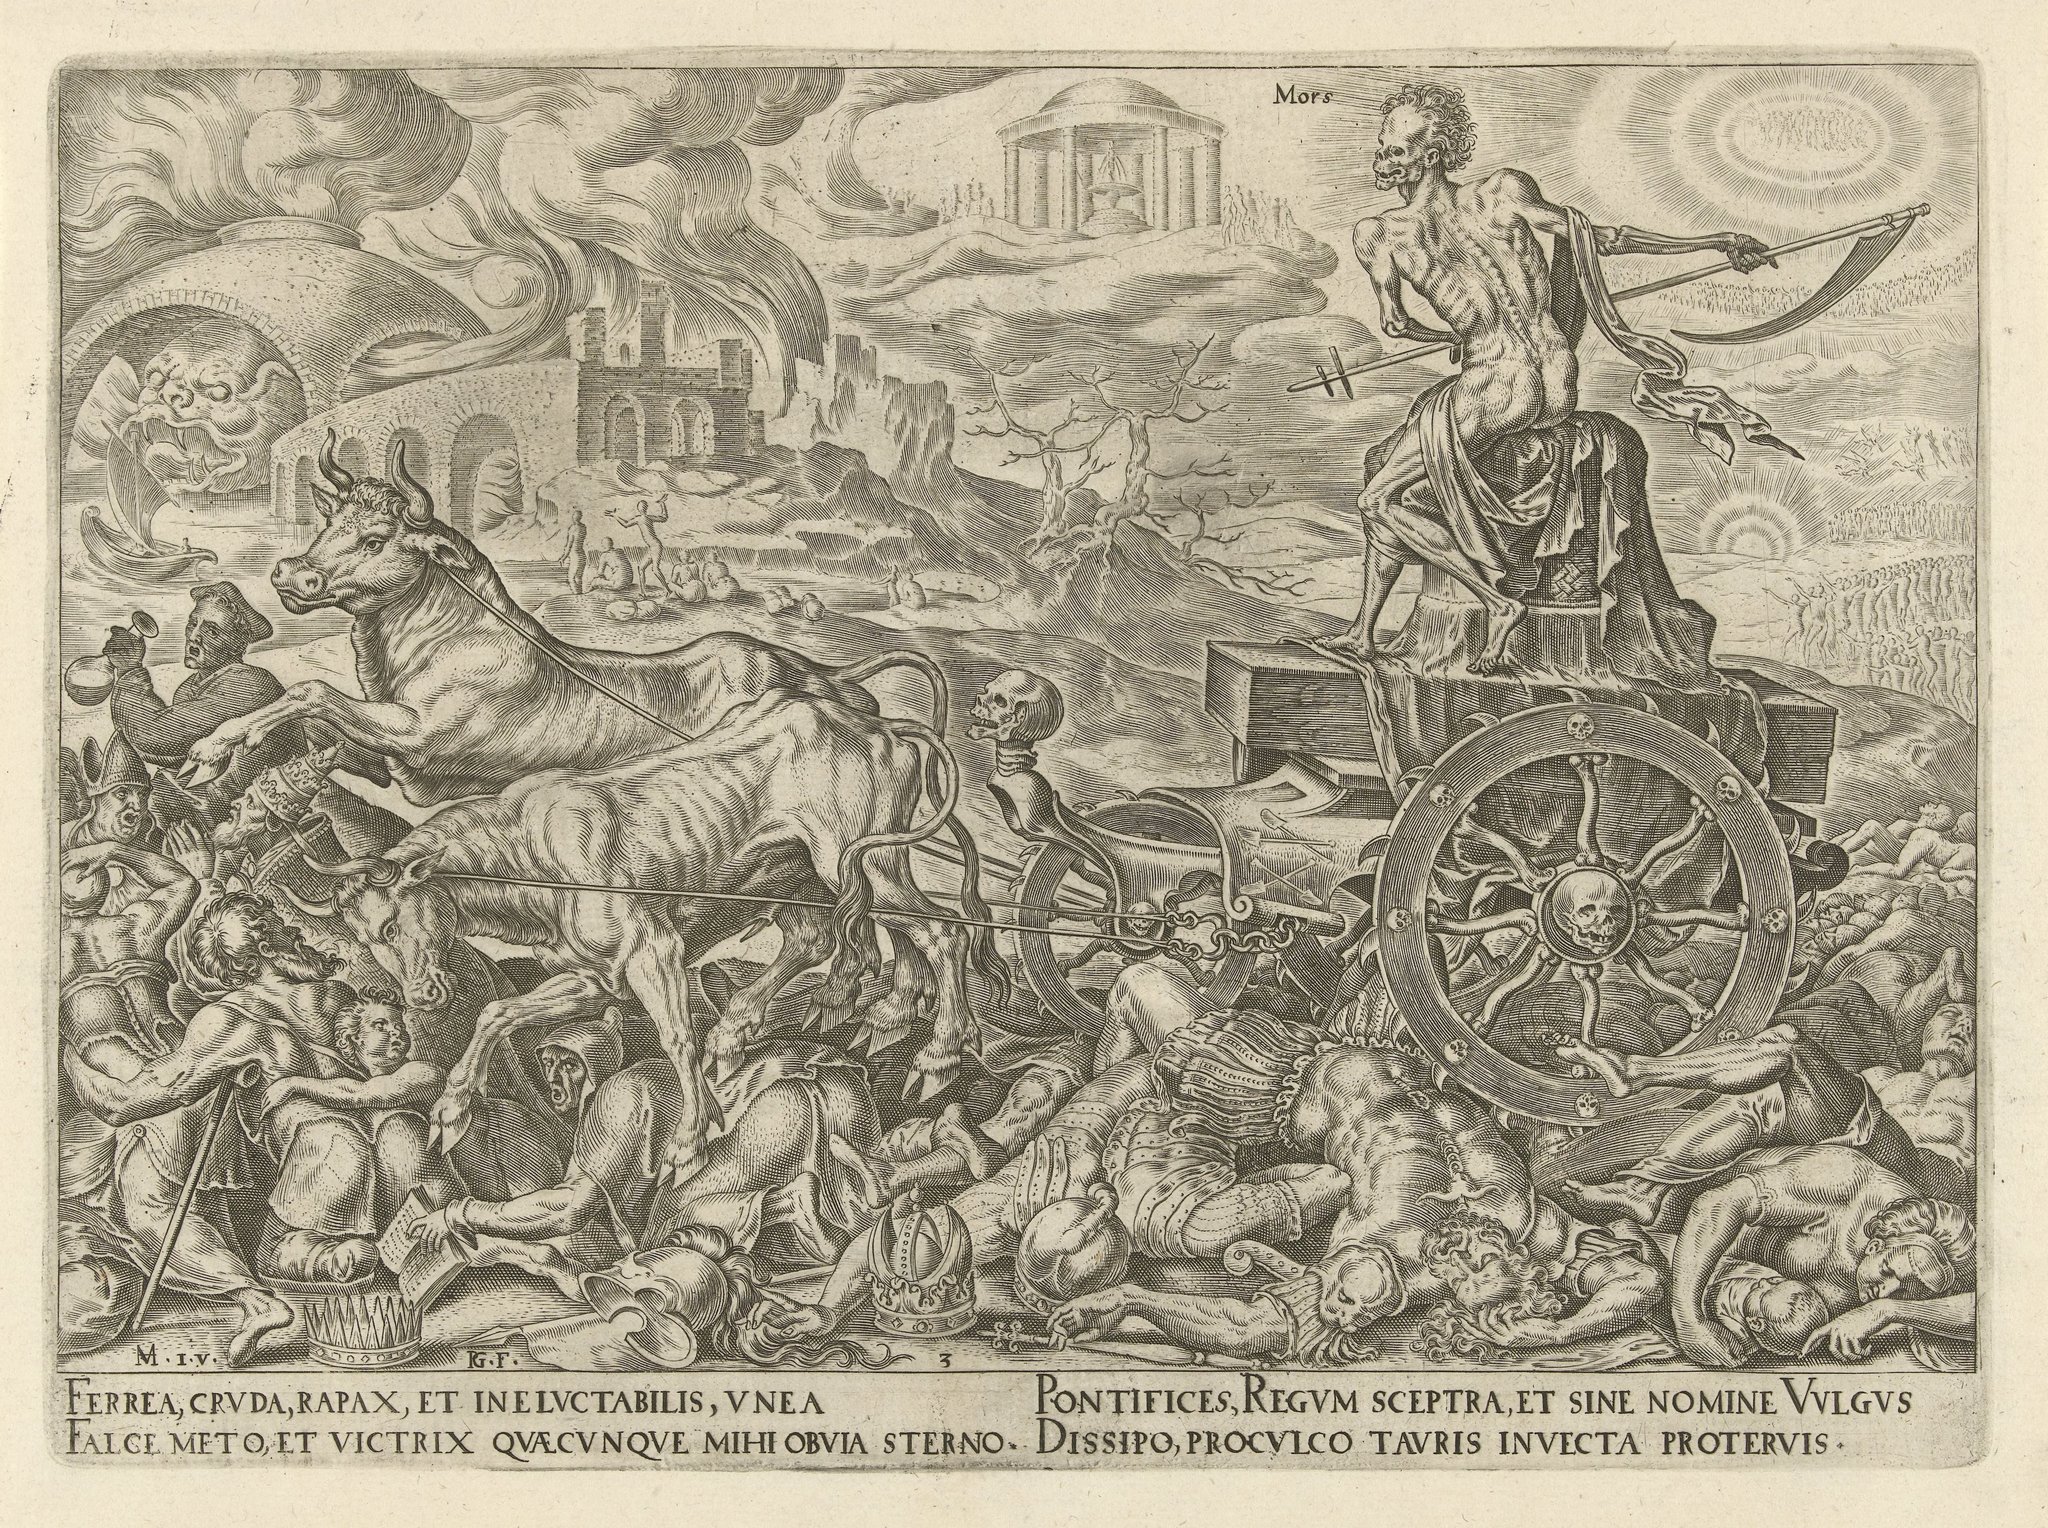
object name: print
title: Triomf van de dood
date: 1565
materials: paper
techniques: engraving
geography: haarlem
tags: entrance of hell as monstrous mouth (of leviathan), 'trionfo della morte', 'triumphus mortis'; 'carro della morte' (ripa)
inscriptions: collector's mark: Lugt 2228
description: De Dood, in de gedaante van een skelet met een zeis, zit op een wagen die versierd is met doodshoofden. De spaken van de wielen bestaan uit knekels.Onder de kar van de Dood wordt iedereen die hij tegenkomt vermorzeld: geestelijken, koningen, generaals en kinderen. Op de achtergrond is te zien wat alle doden uiteindelijk te wachten staat: links een brandende hel en rechts de opkomende zon van het paradijs. De prent heeft een Latijns onderschrift en is een deel van de serie over de triomfen van Petrarca.